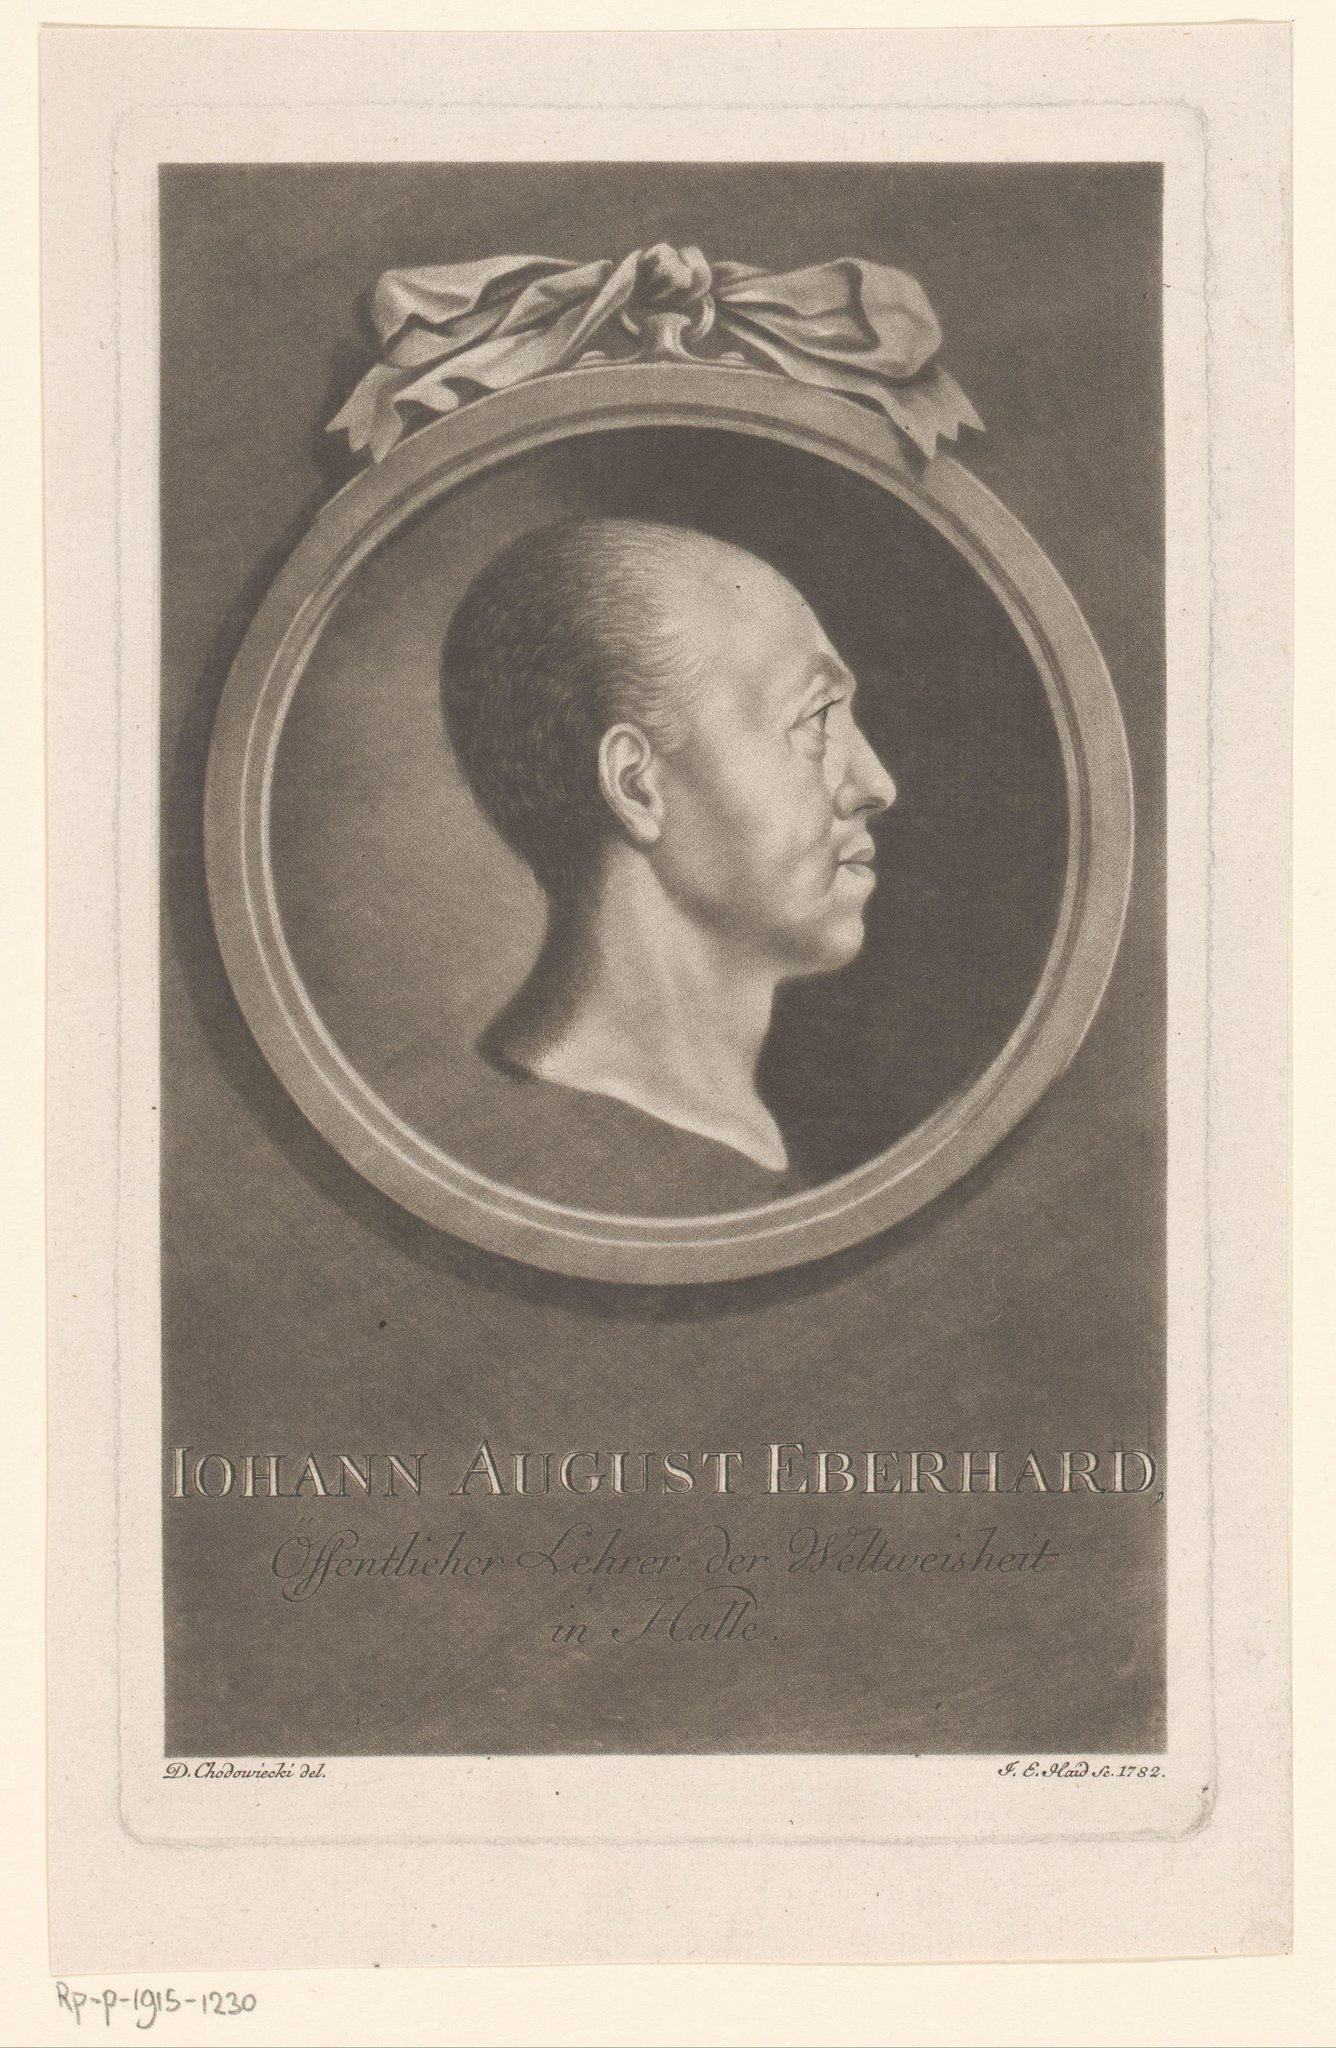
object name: print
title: Portret van Johann August Eberhard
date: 1782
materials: paper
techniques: mezzotint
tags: scholar, philosopher, ornament ~ medallion, historical persons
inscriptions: collector's mark: Lugt 2228